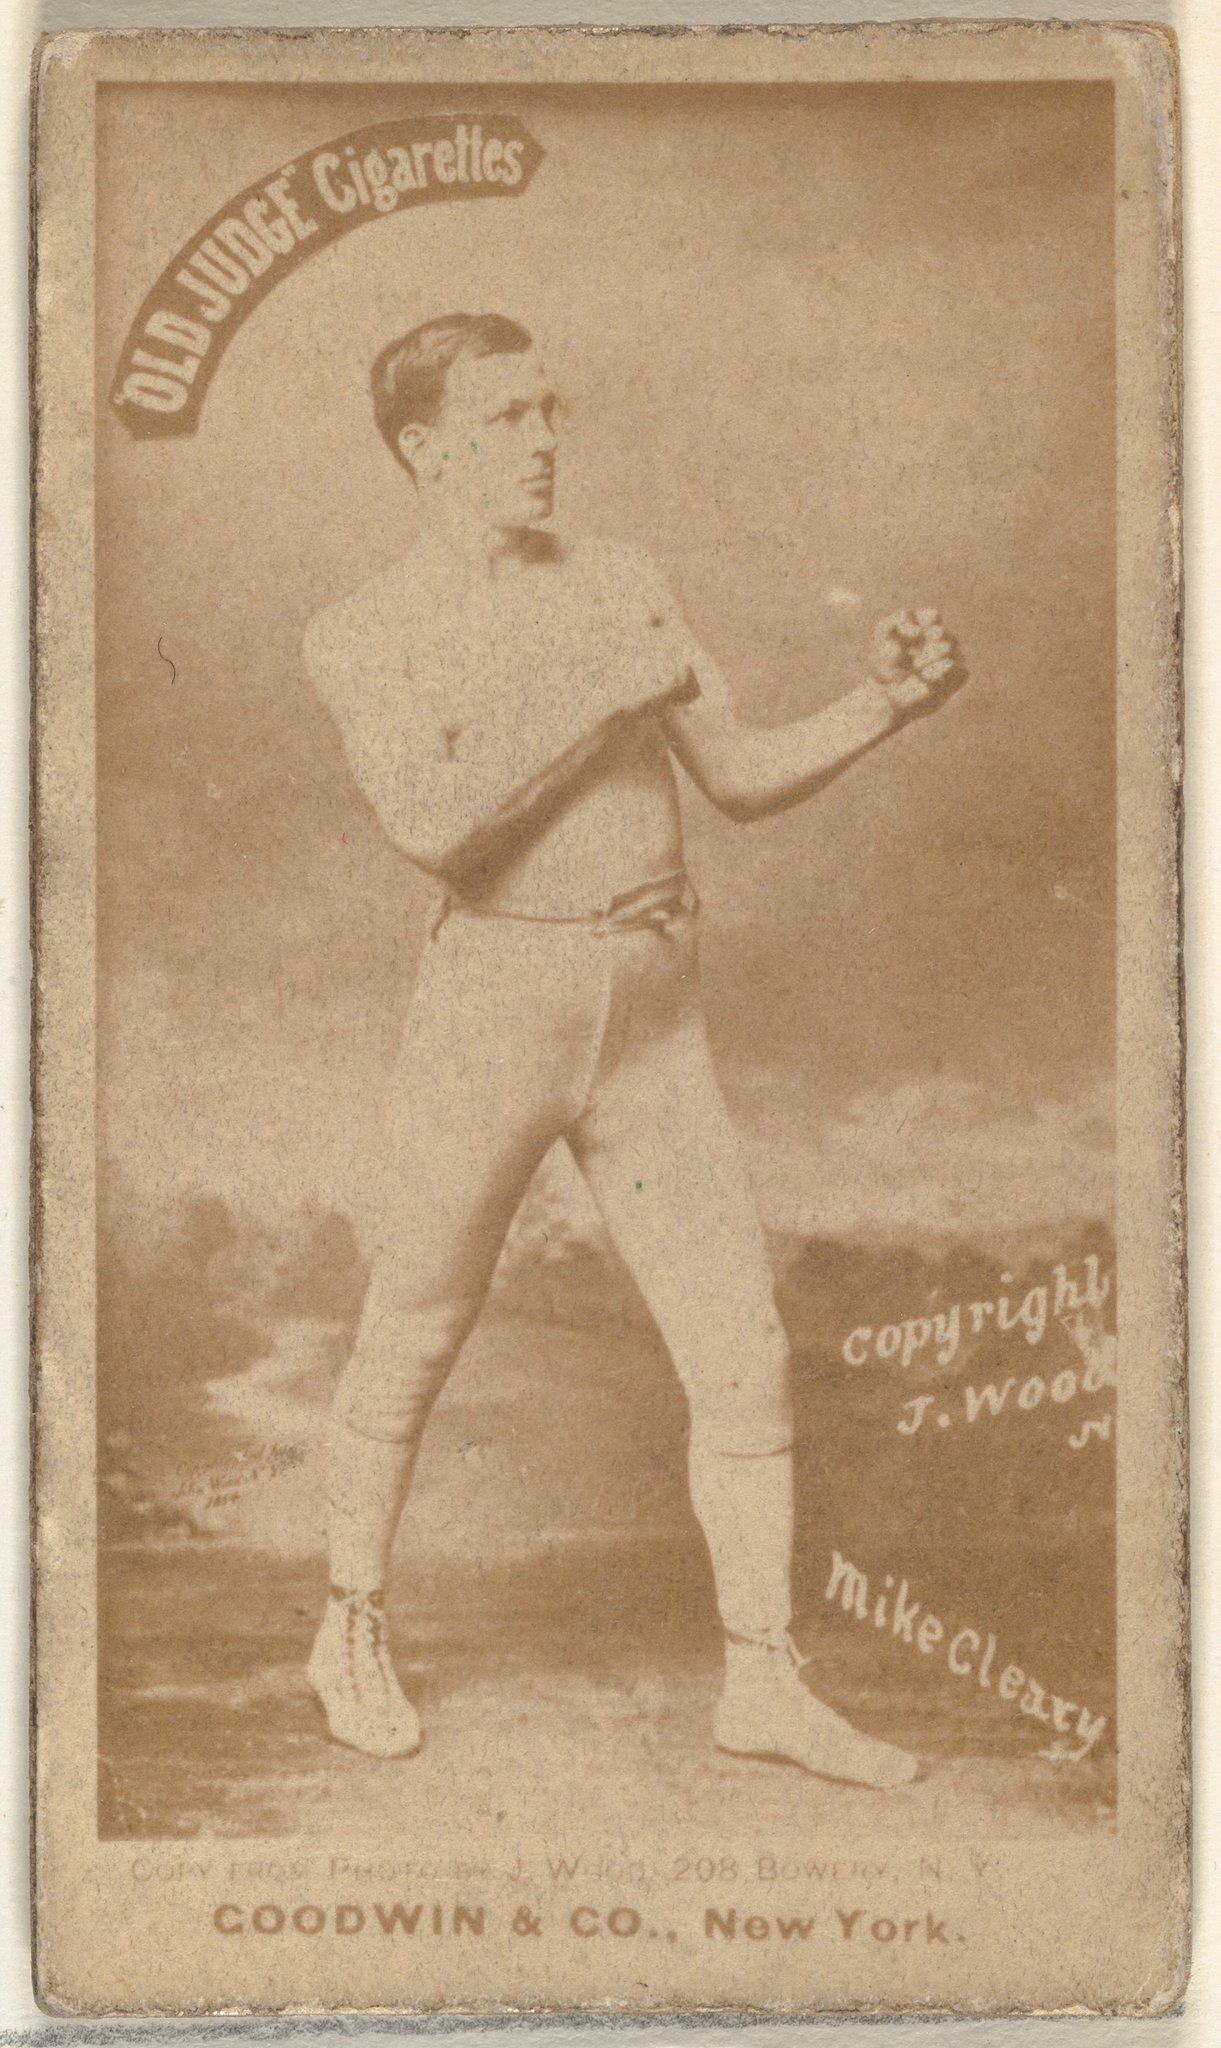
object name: photograph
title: Mike Cleary, from the Celebrities and Prizefighters series (N174) for Old Judge Cigarettes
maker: goodwin & company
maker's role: publisher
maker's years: 1850-1950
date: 1887-1888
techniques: albumen silver print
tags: men,portraits,baseball,athletes